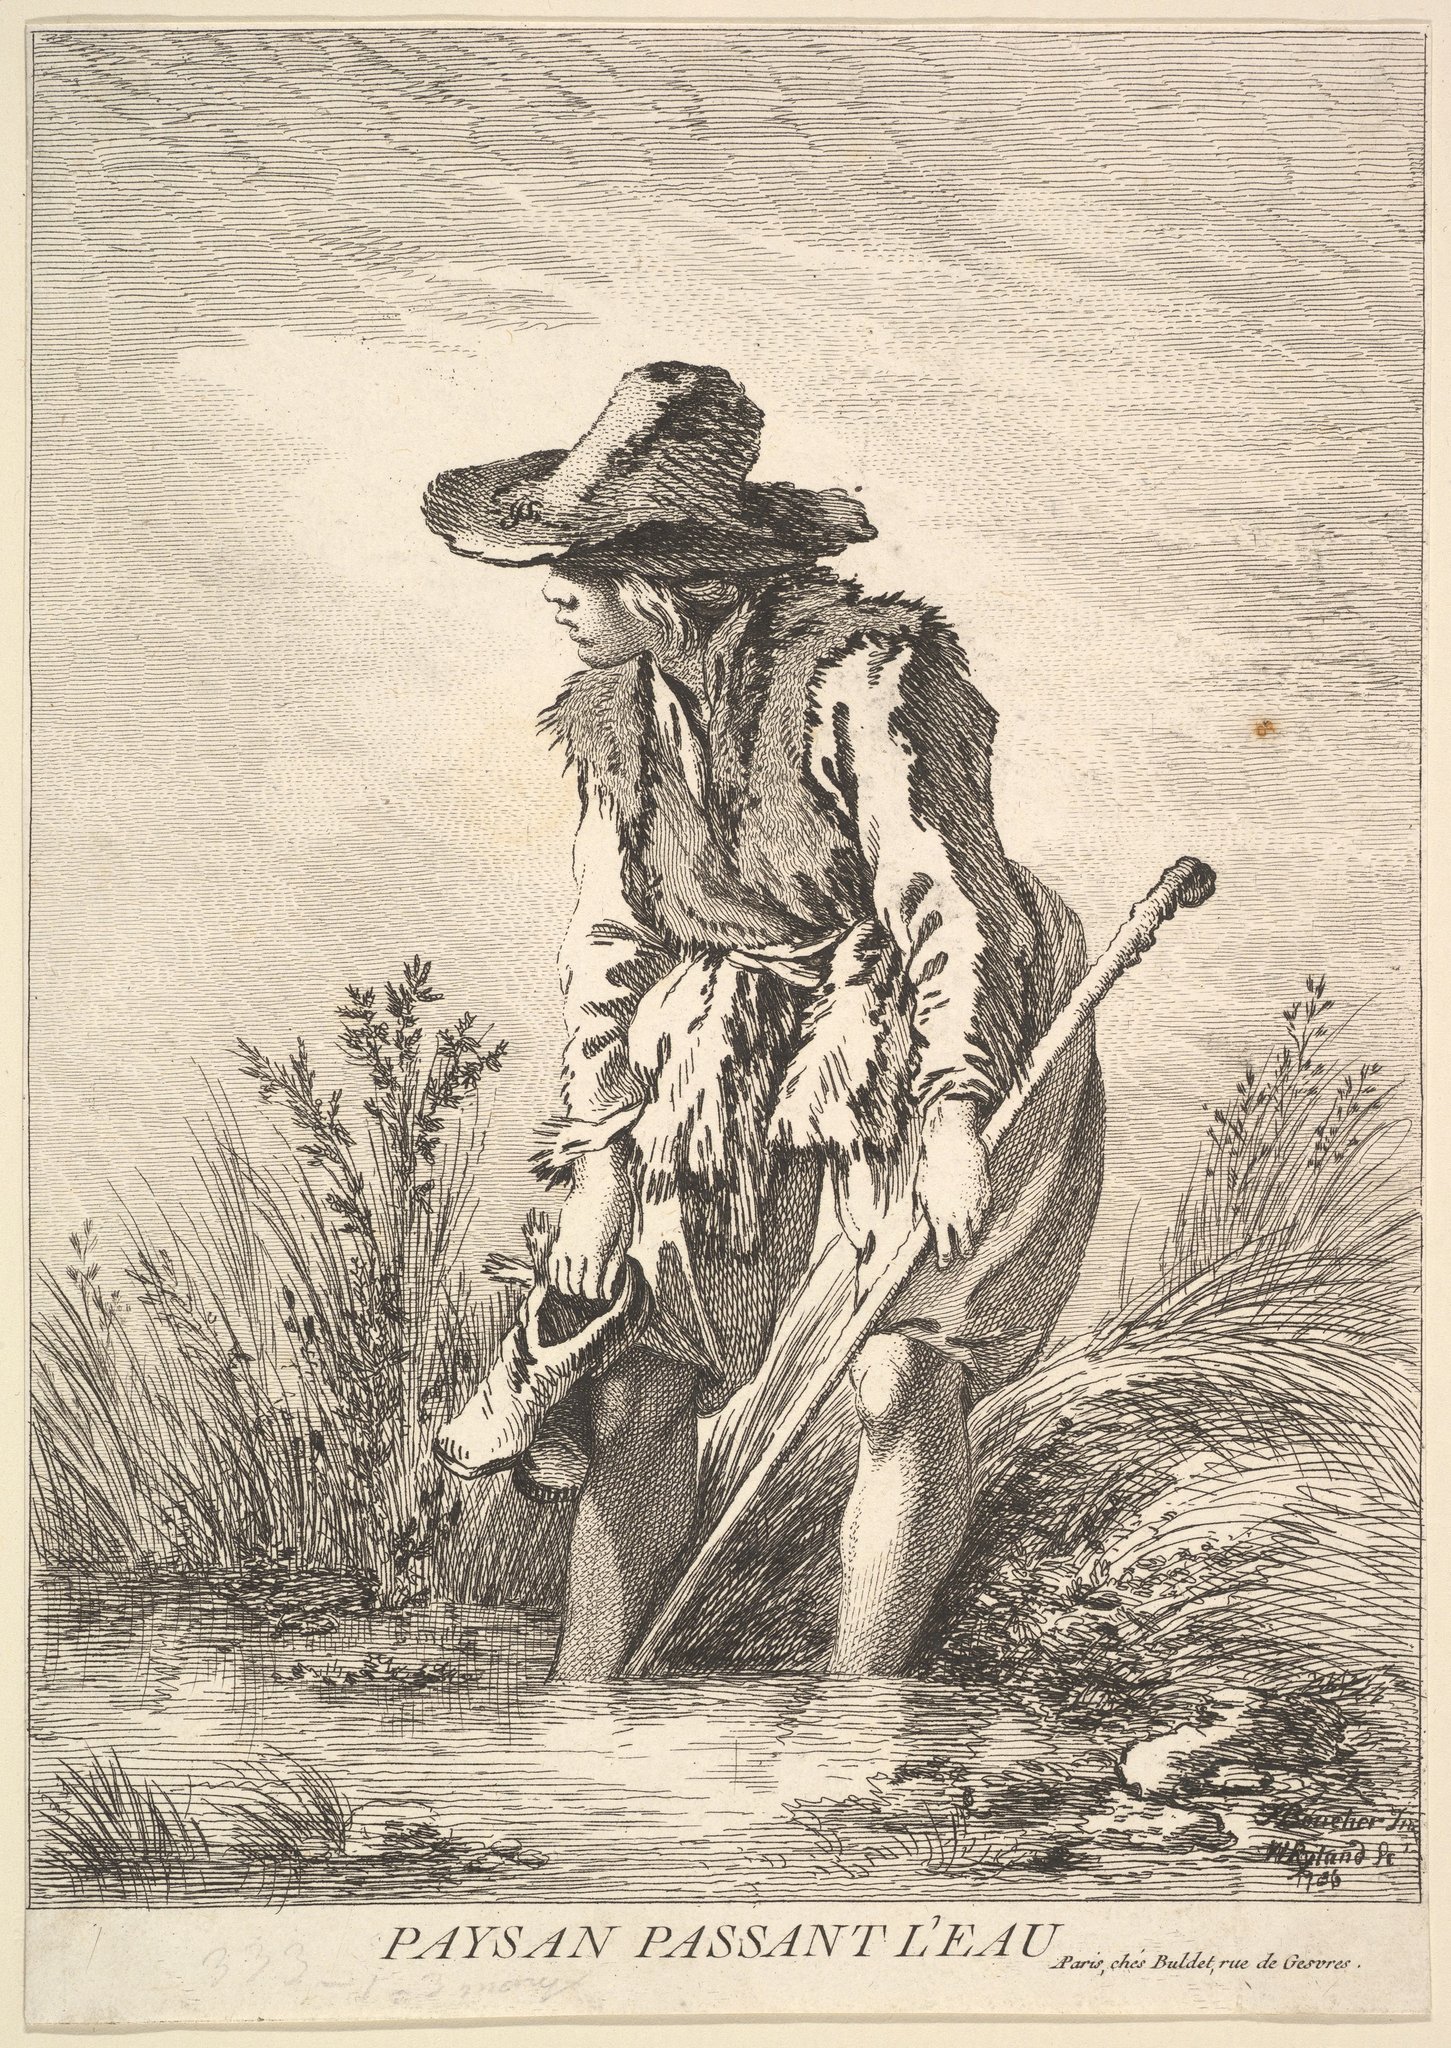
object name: print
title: Peasant Crossing Water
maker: william wynne ryland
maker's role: artist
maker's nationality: british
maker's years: 1732-1783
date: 1786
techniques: engraving, etching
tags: shoes,men